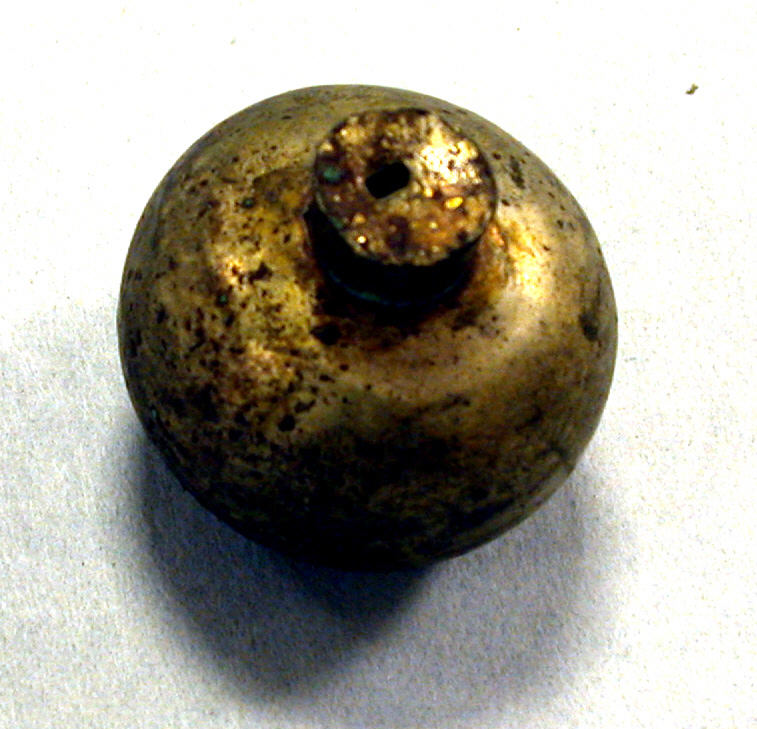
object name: bead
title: Hammered Silver Bead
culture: peruvian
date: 701-1566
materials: gilt, silver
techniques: hammering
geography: peru